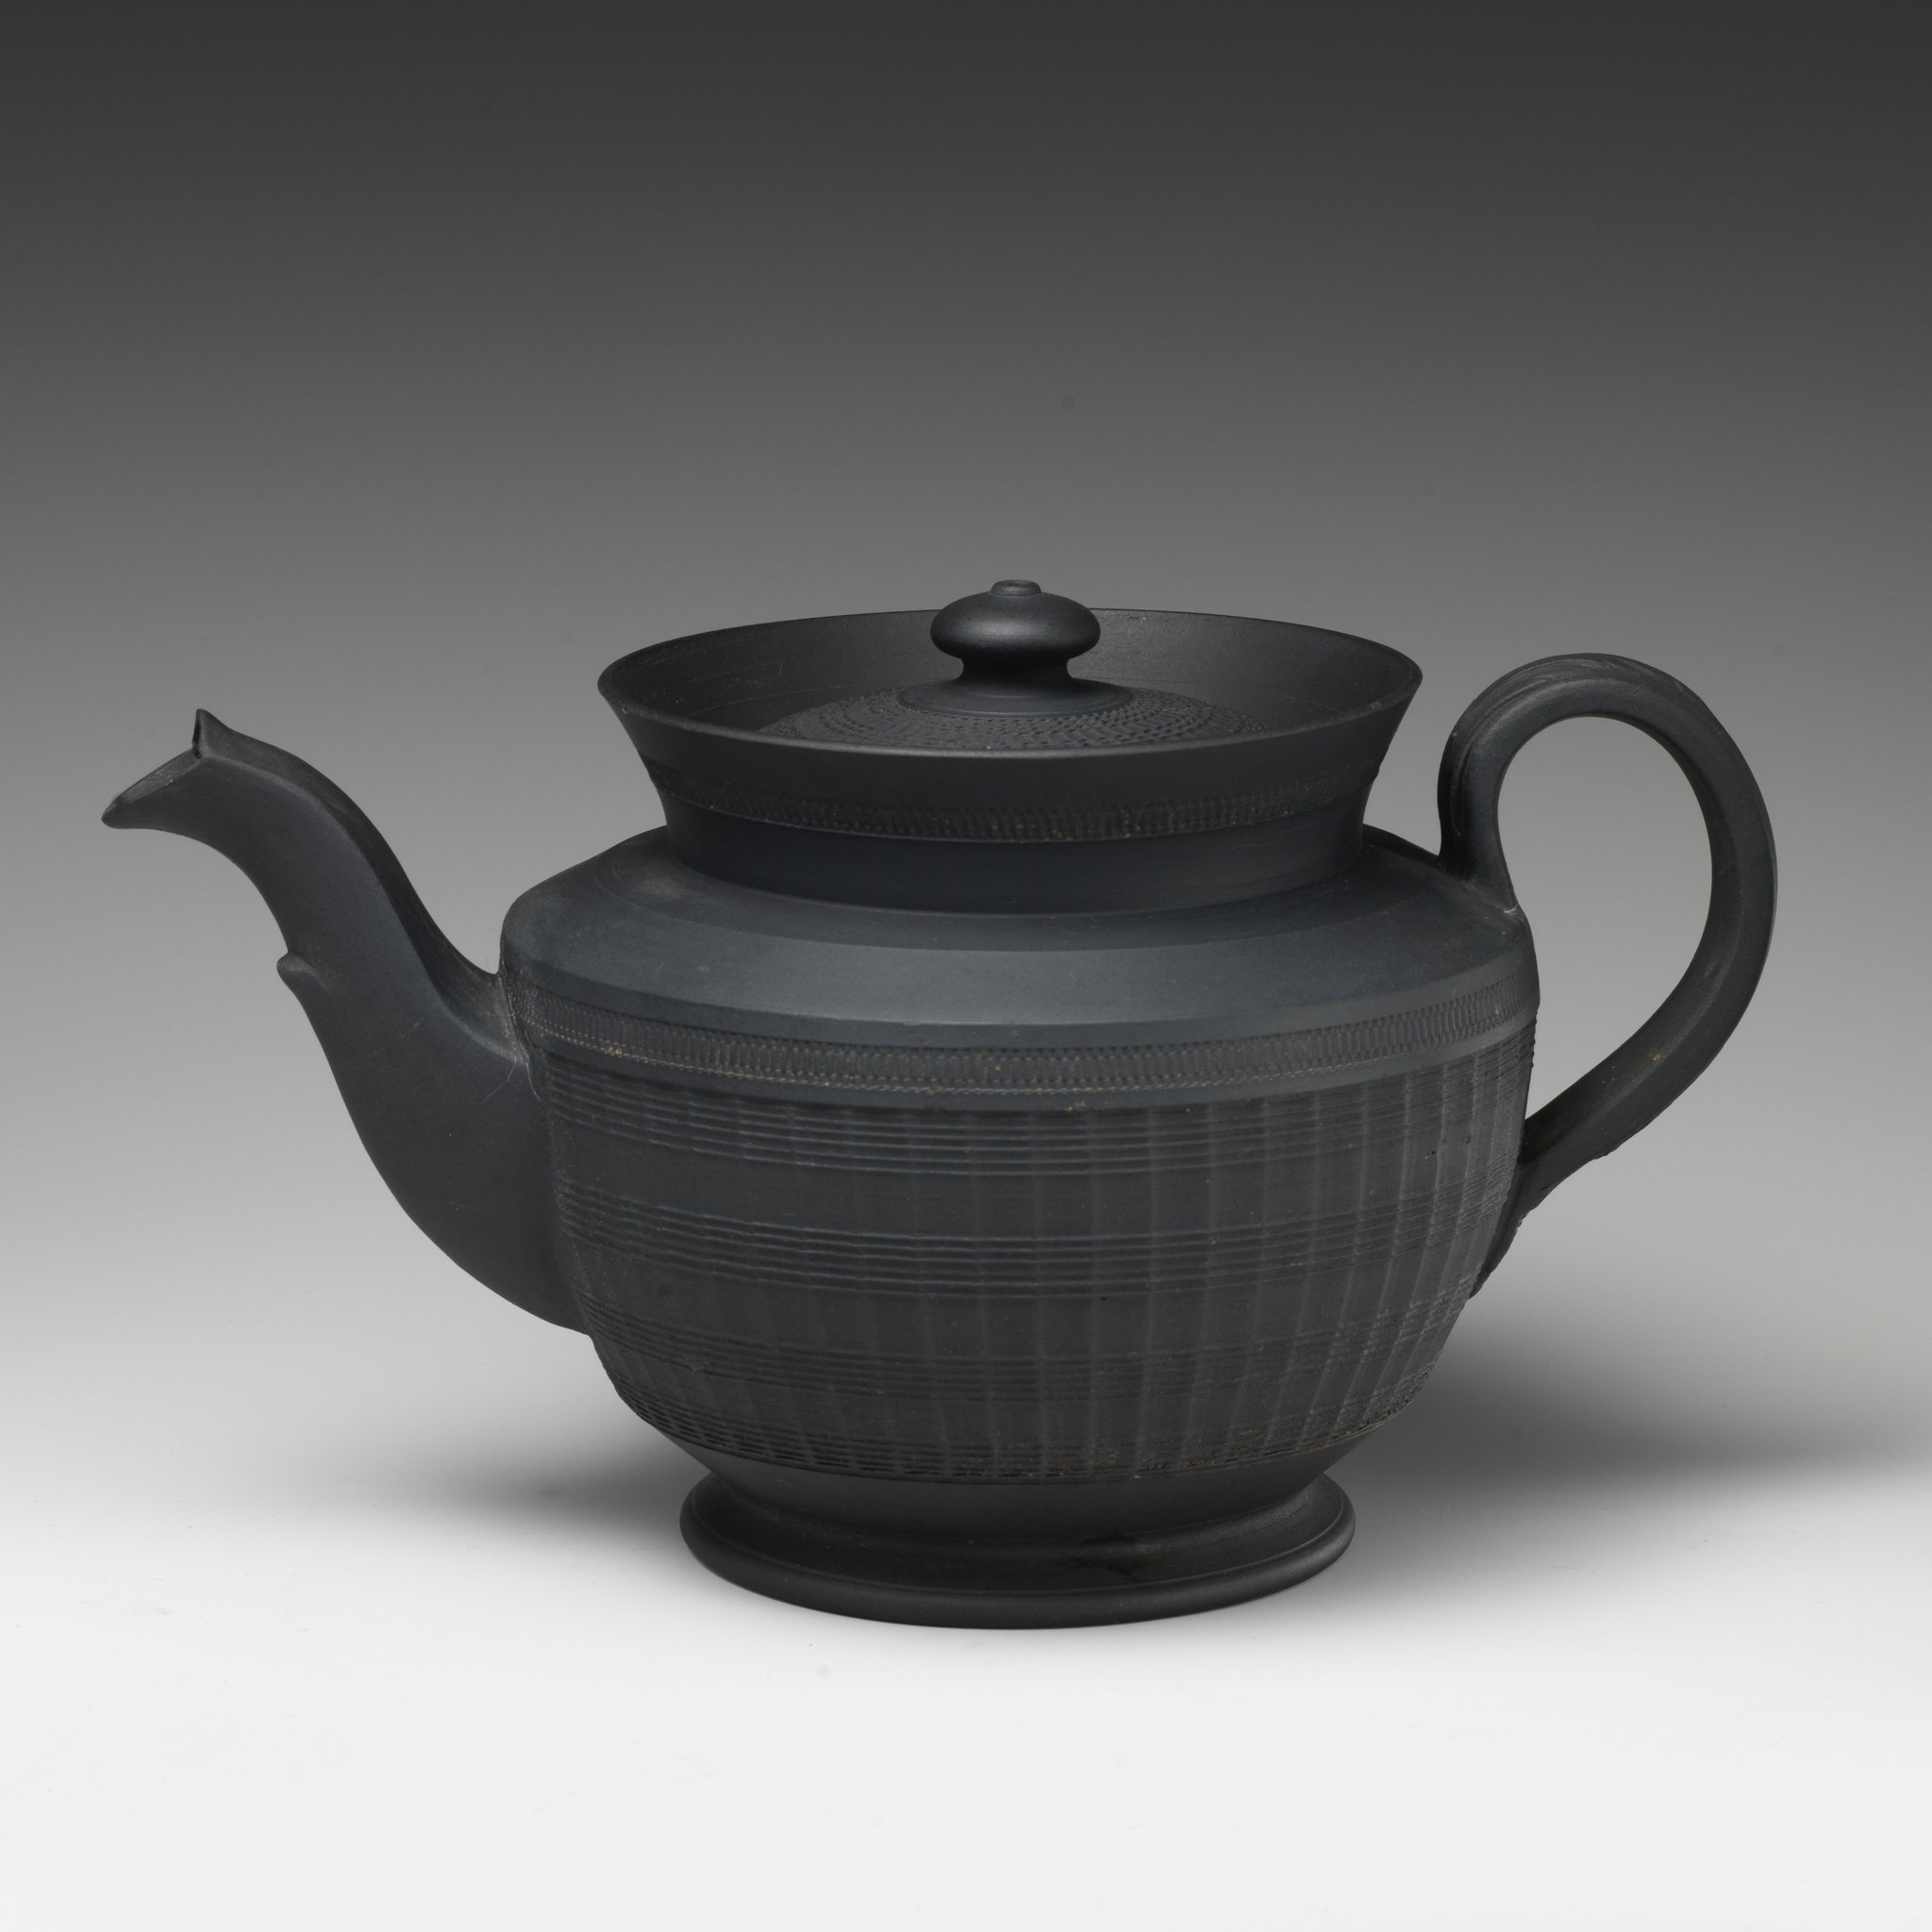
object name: teapot with cover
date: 1801-1833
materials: stone